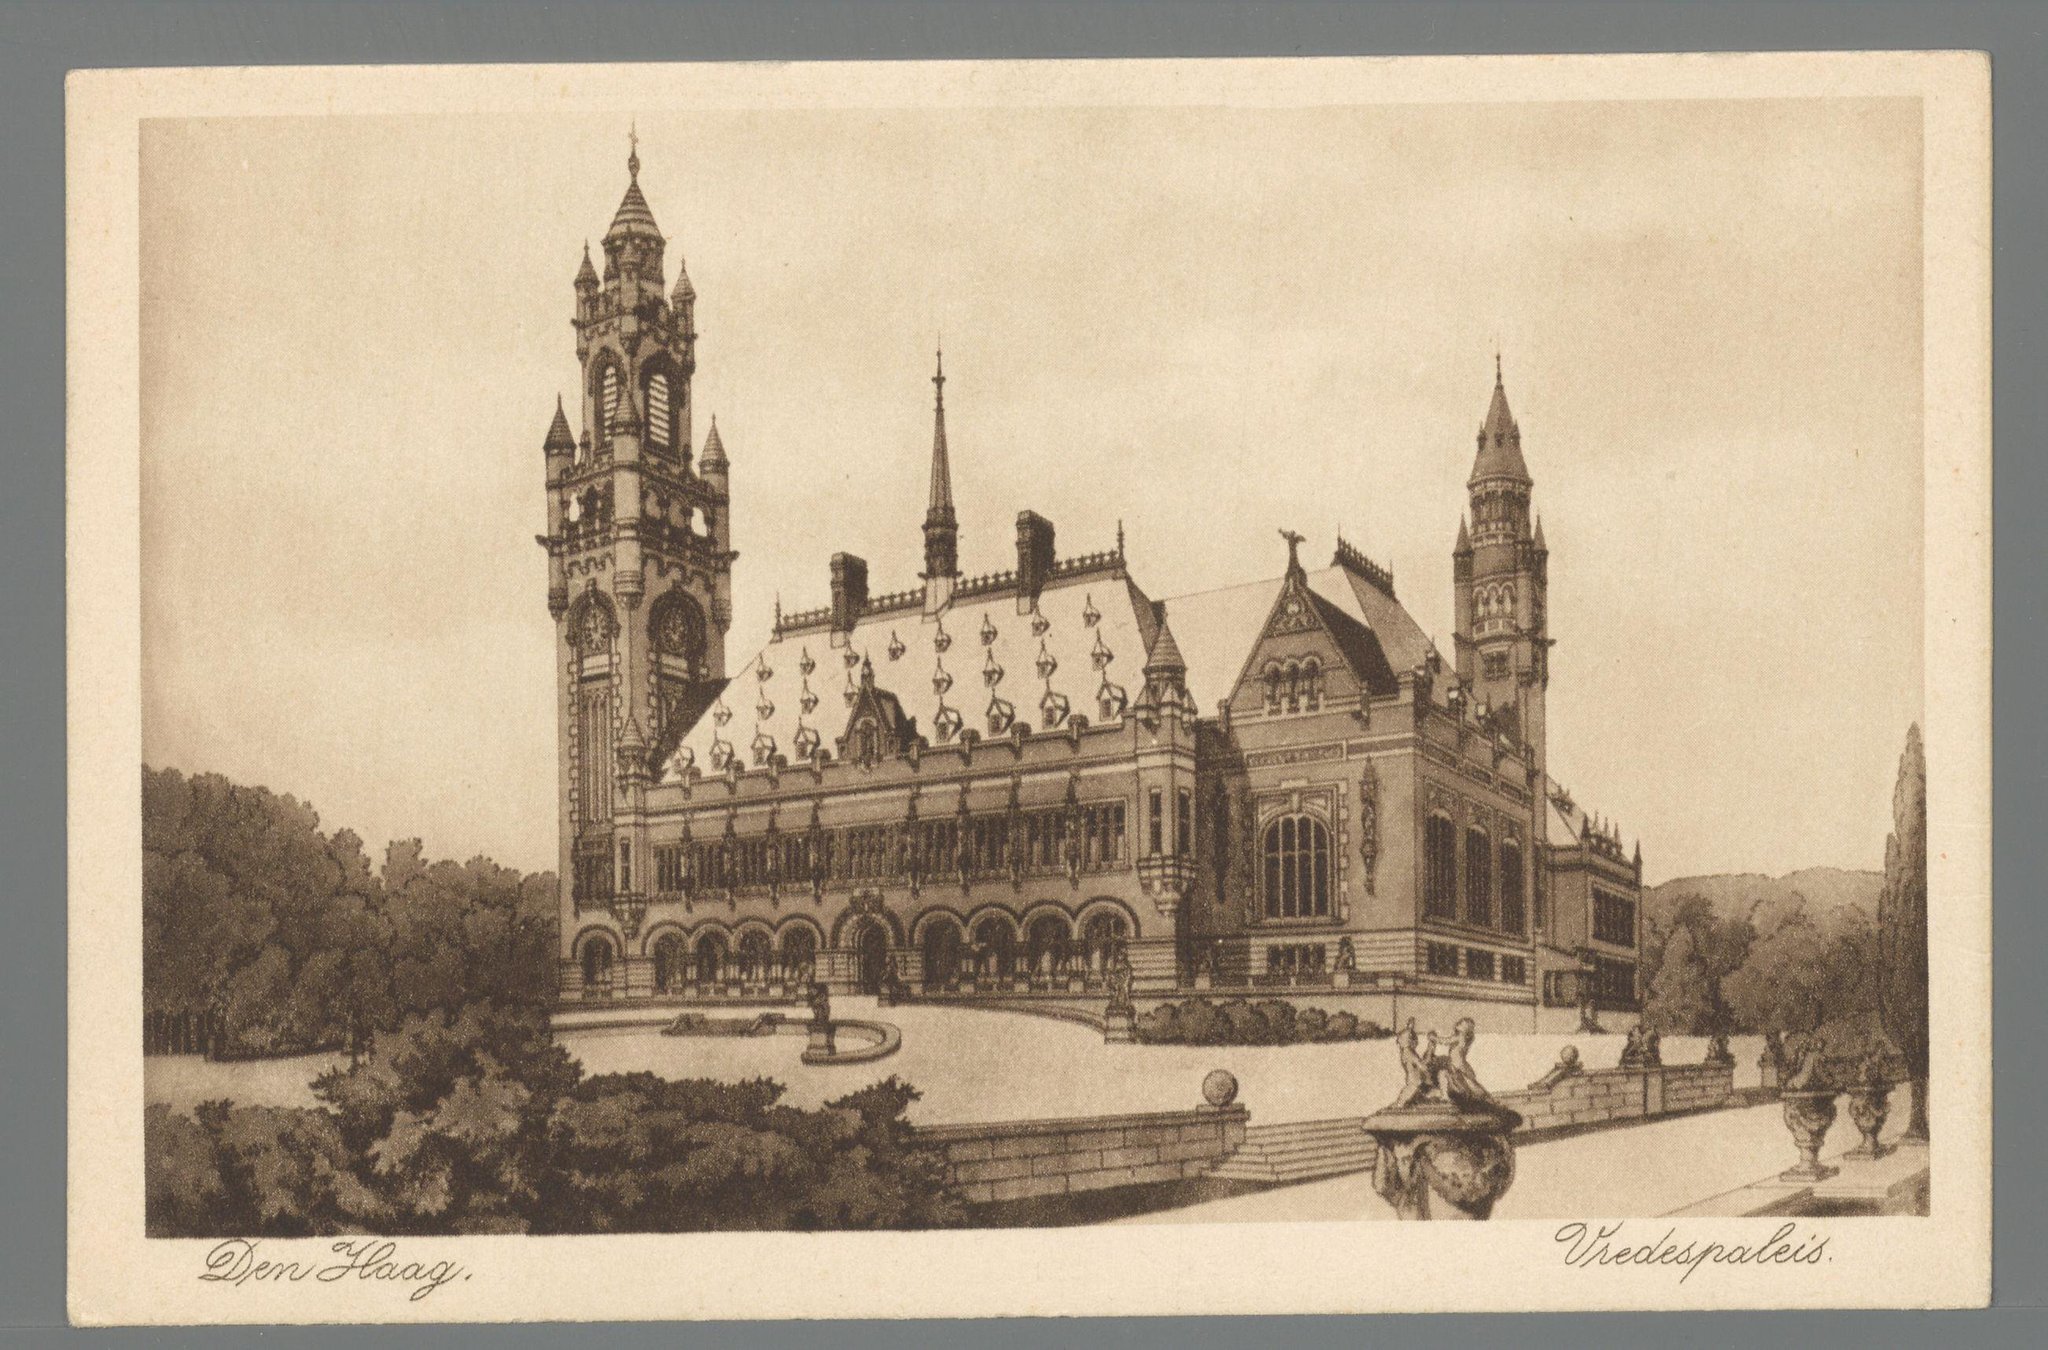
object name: photomechanical print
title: Den Haag. Vredespaleis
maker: Anonymous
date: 1913-1950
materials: cardboard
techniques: rotogravure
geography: the hague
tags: palace